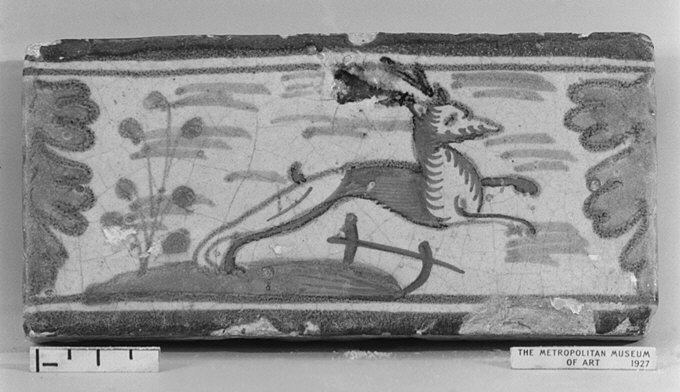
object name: tile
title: Border tile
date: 1601-1633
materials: earthenware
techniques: glazing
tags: deer